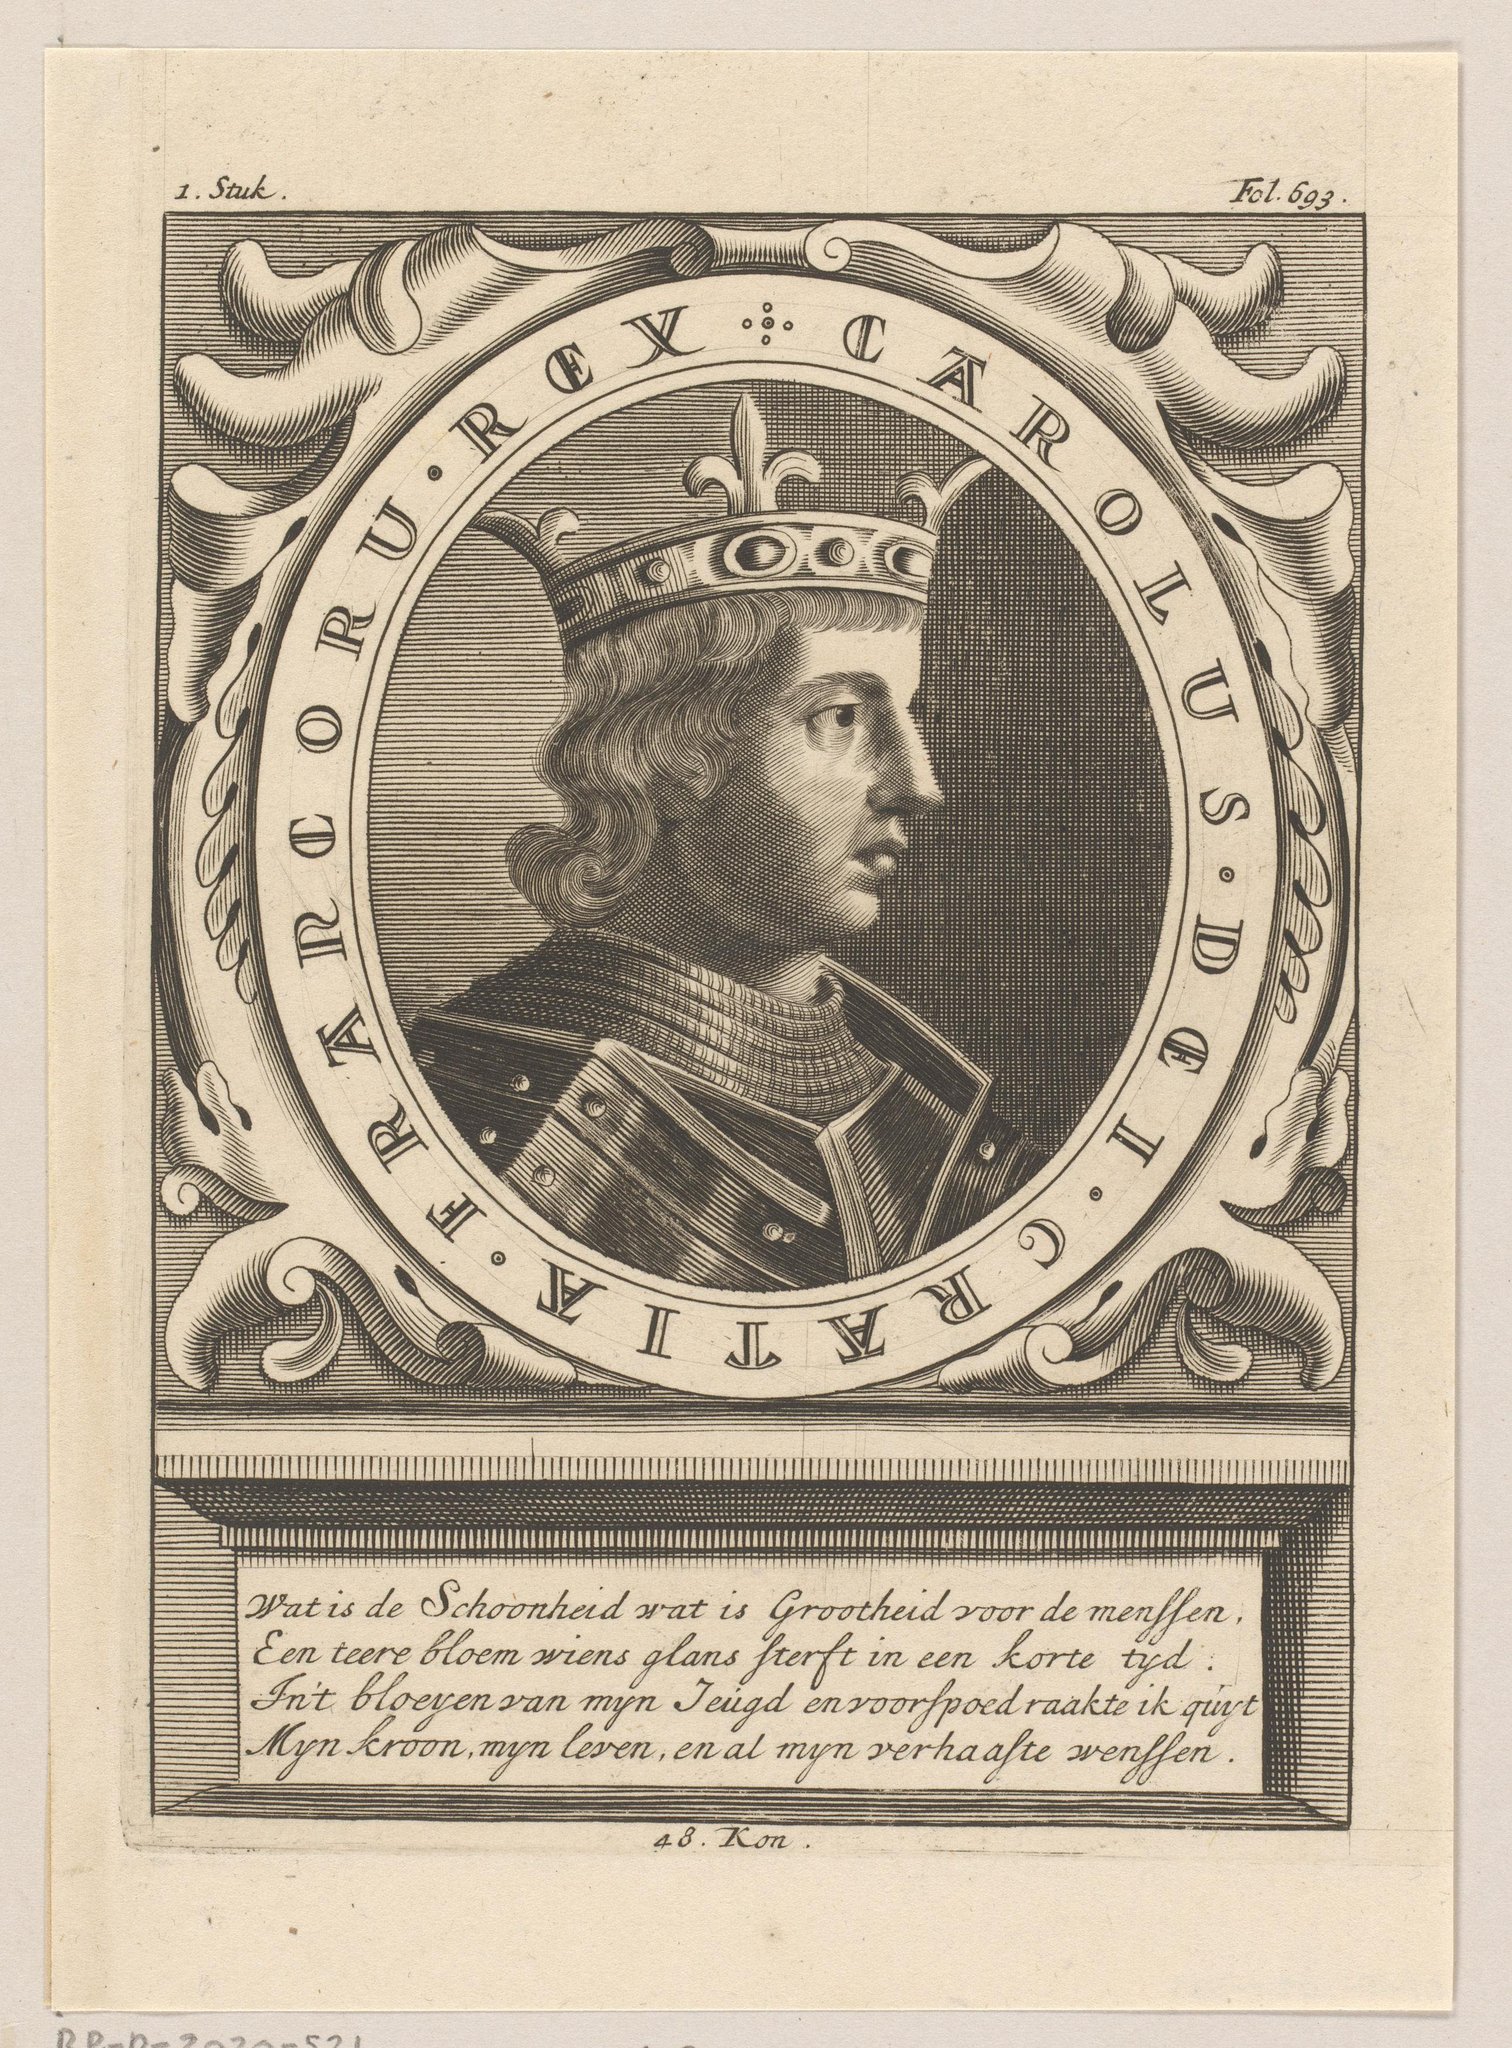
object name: print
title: Carolus dei gratia Francoru rex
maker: Anonymous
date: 1685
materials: paper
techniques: engraving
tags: historical persons, king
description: Prent gebruikt in: Eudes de Mézeray, François. Chronyk van Vrankryk. 6 dln. Amsterdam: Jan Bouman en Timotheum ten Hoorn, 1685, dl. 2.